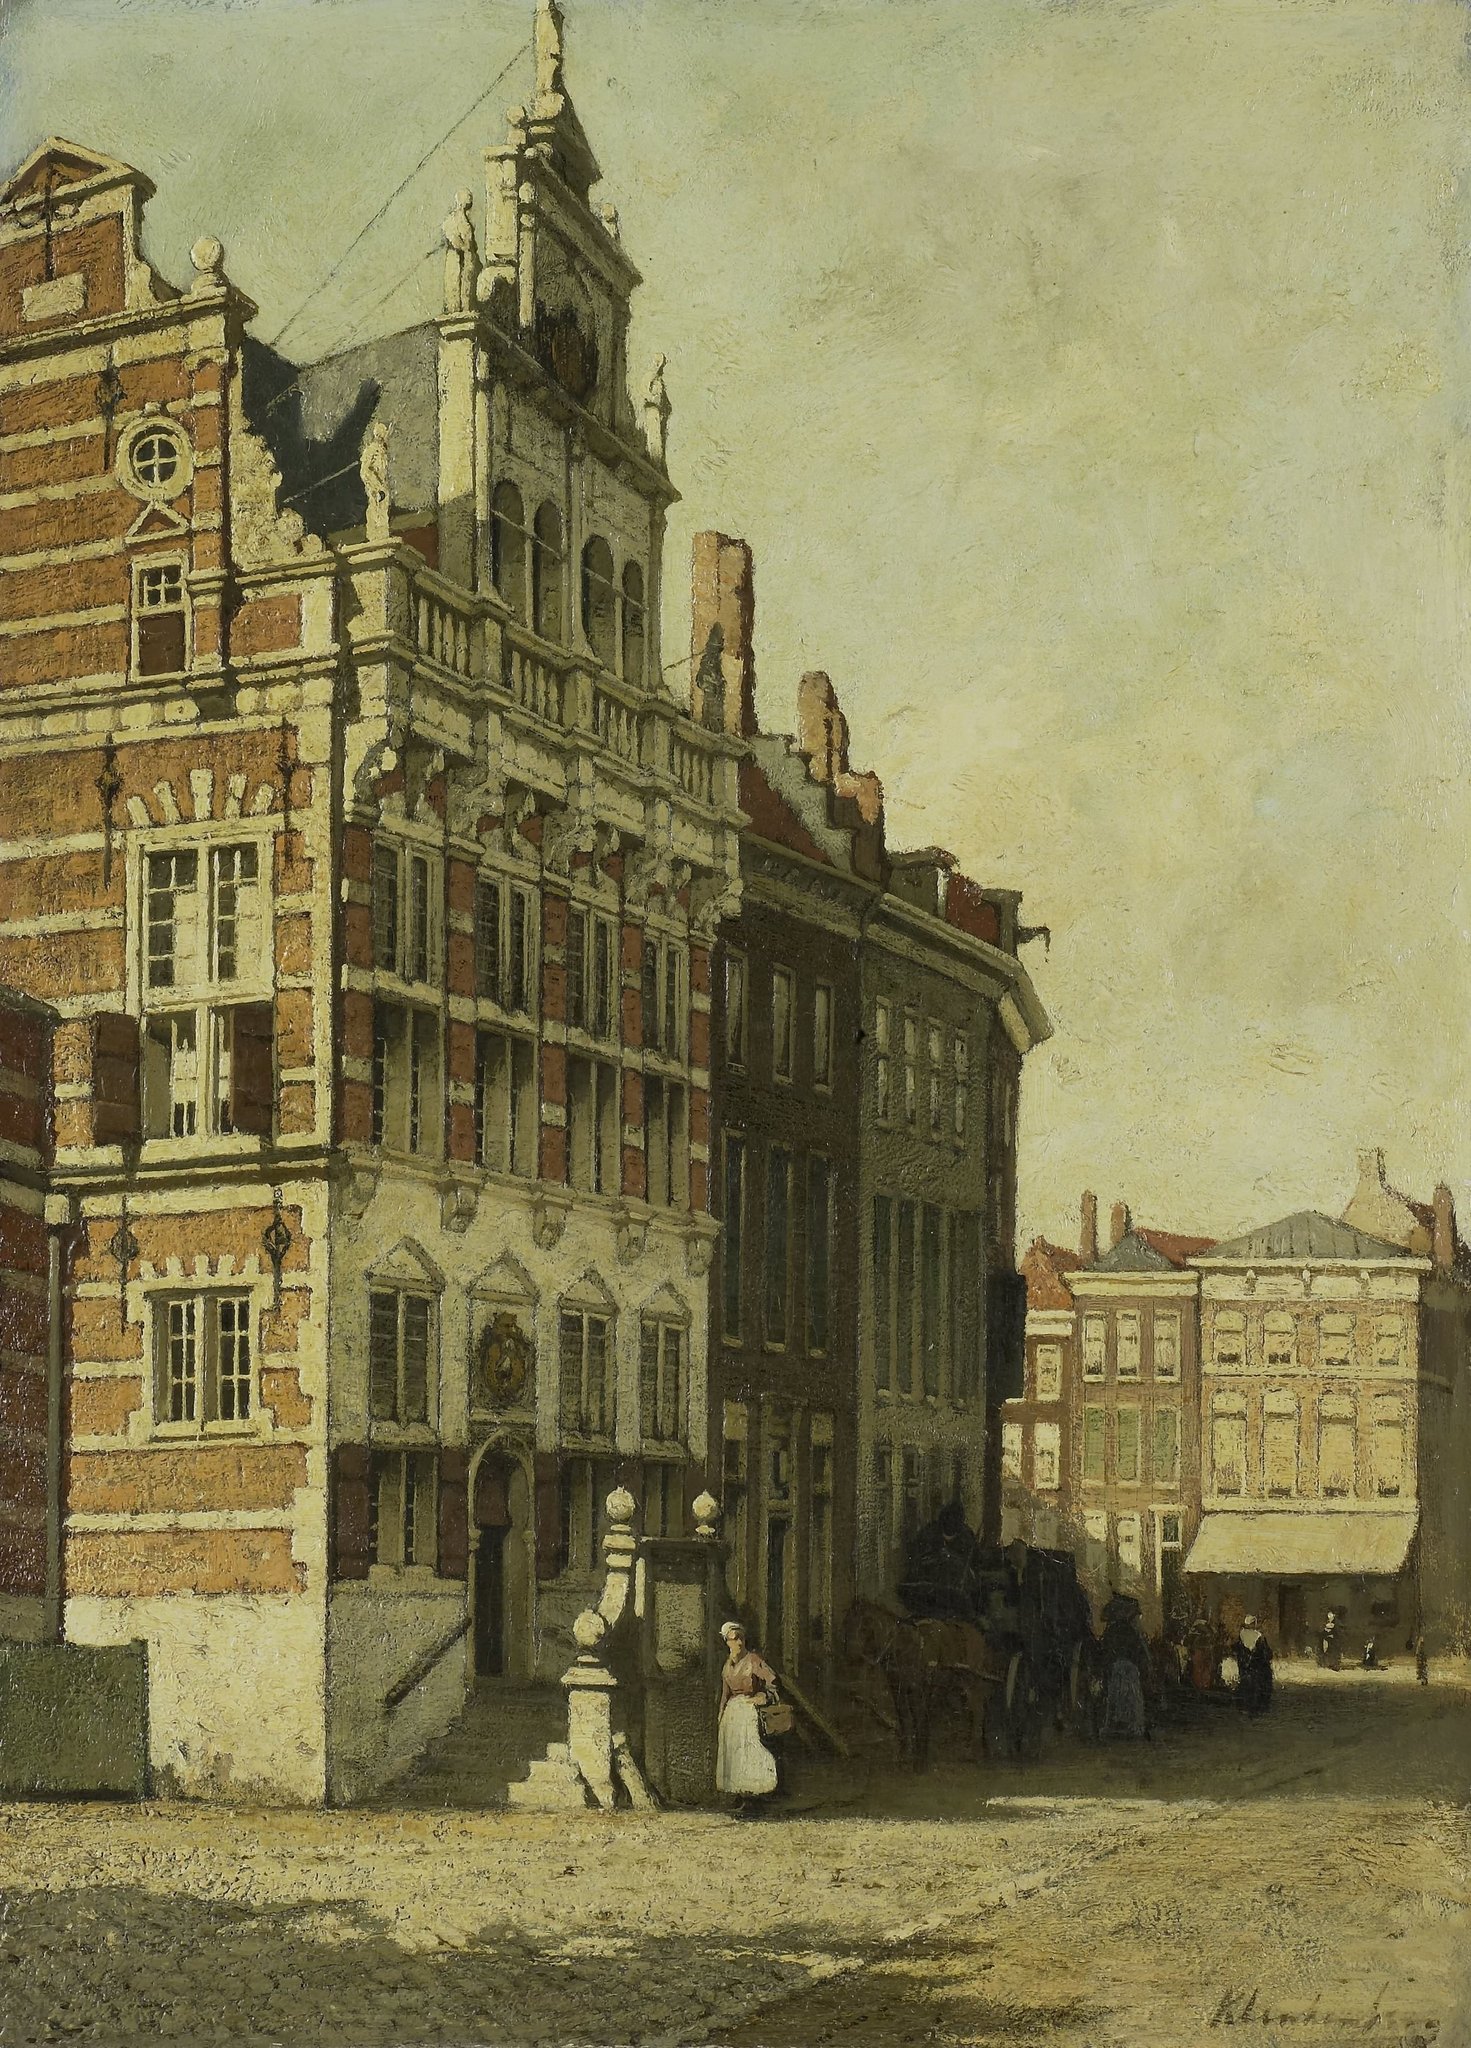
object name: painting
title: The Town Hall, The Hague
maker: johannes christiaan karel klinkenberg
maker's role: draughtsman, painter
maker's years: 1852-1924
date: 1875-1907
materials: oil, panel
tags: city-view in general; 'veduta', townhall, the hague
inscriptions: signature: ‘Klinkenberg’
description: Het stadhuis in Den Haag. Bij de trap loopt een vrouw met een mand, rechts in de schaduw staat een rijtuig.